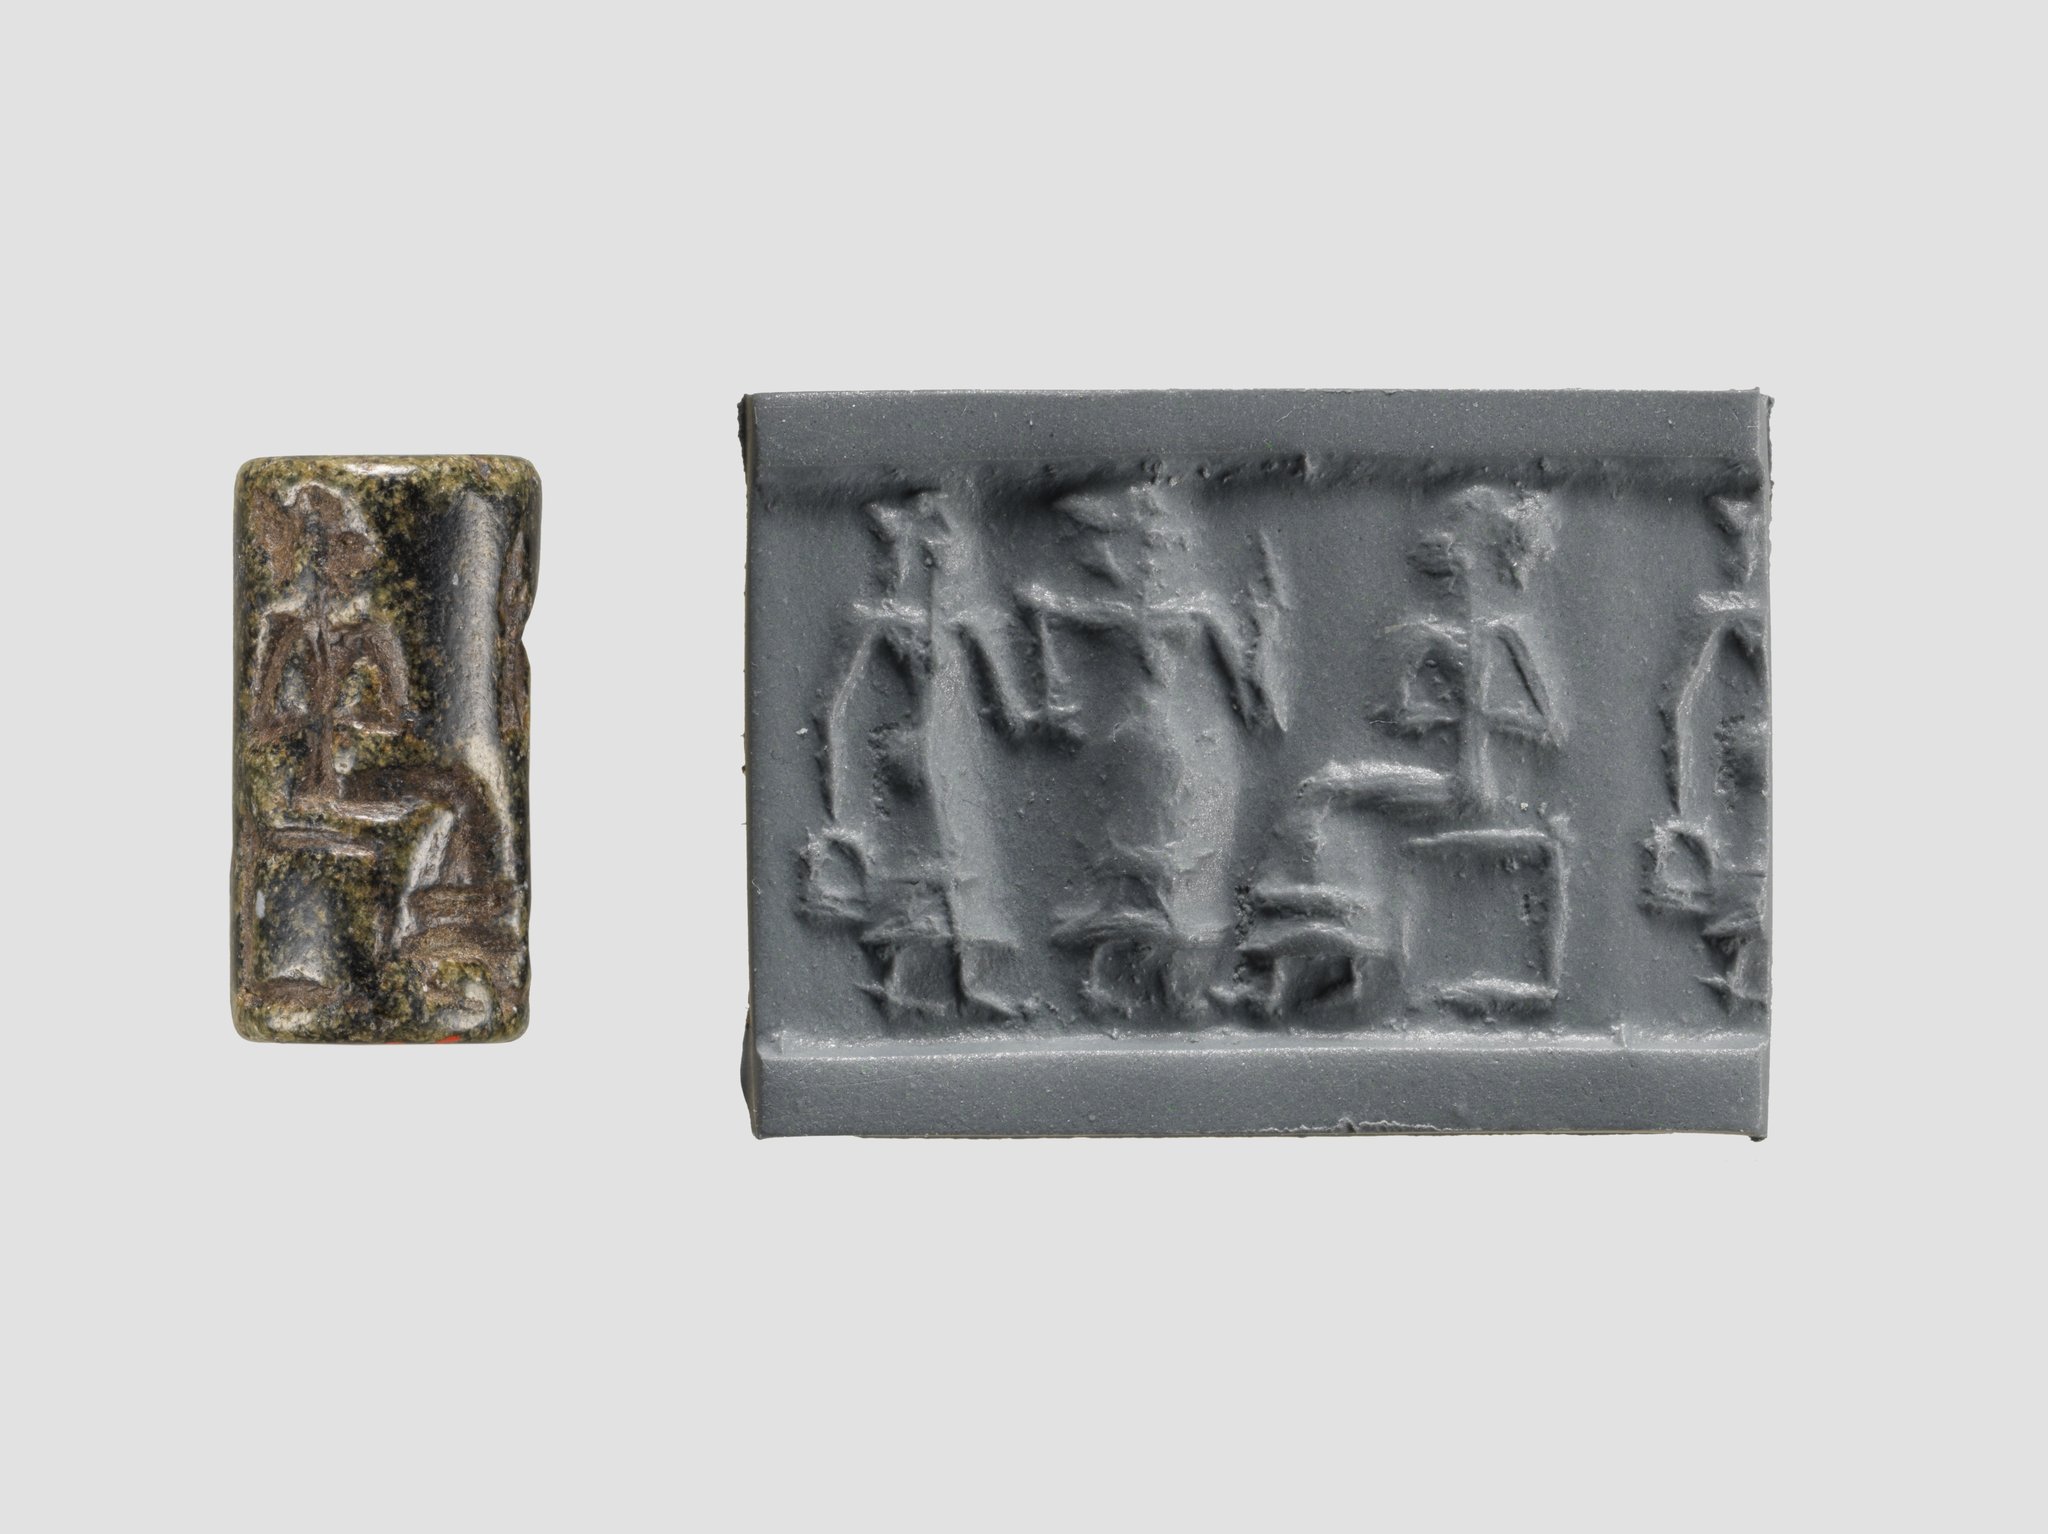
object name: cylinder seal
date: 2150-2100 BCE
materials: stone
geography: mesopotamia